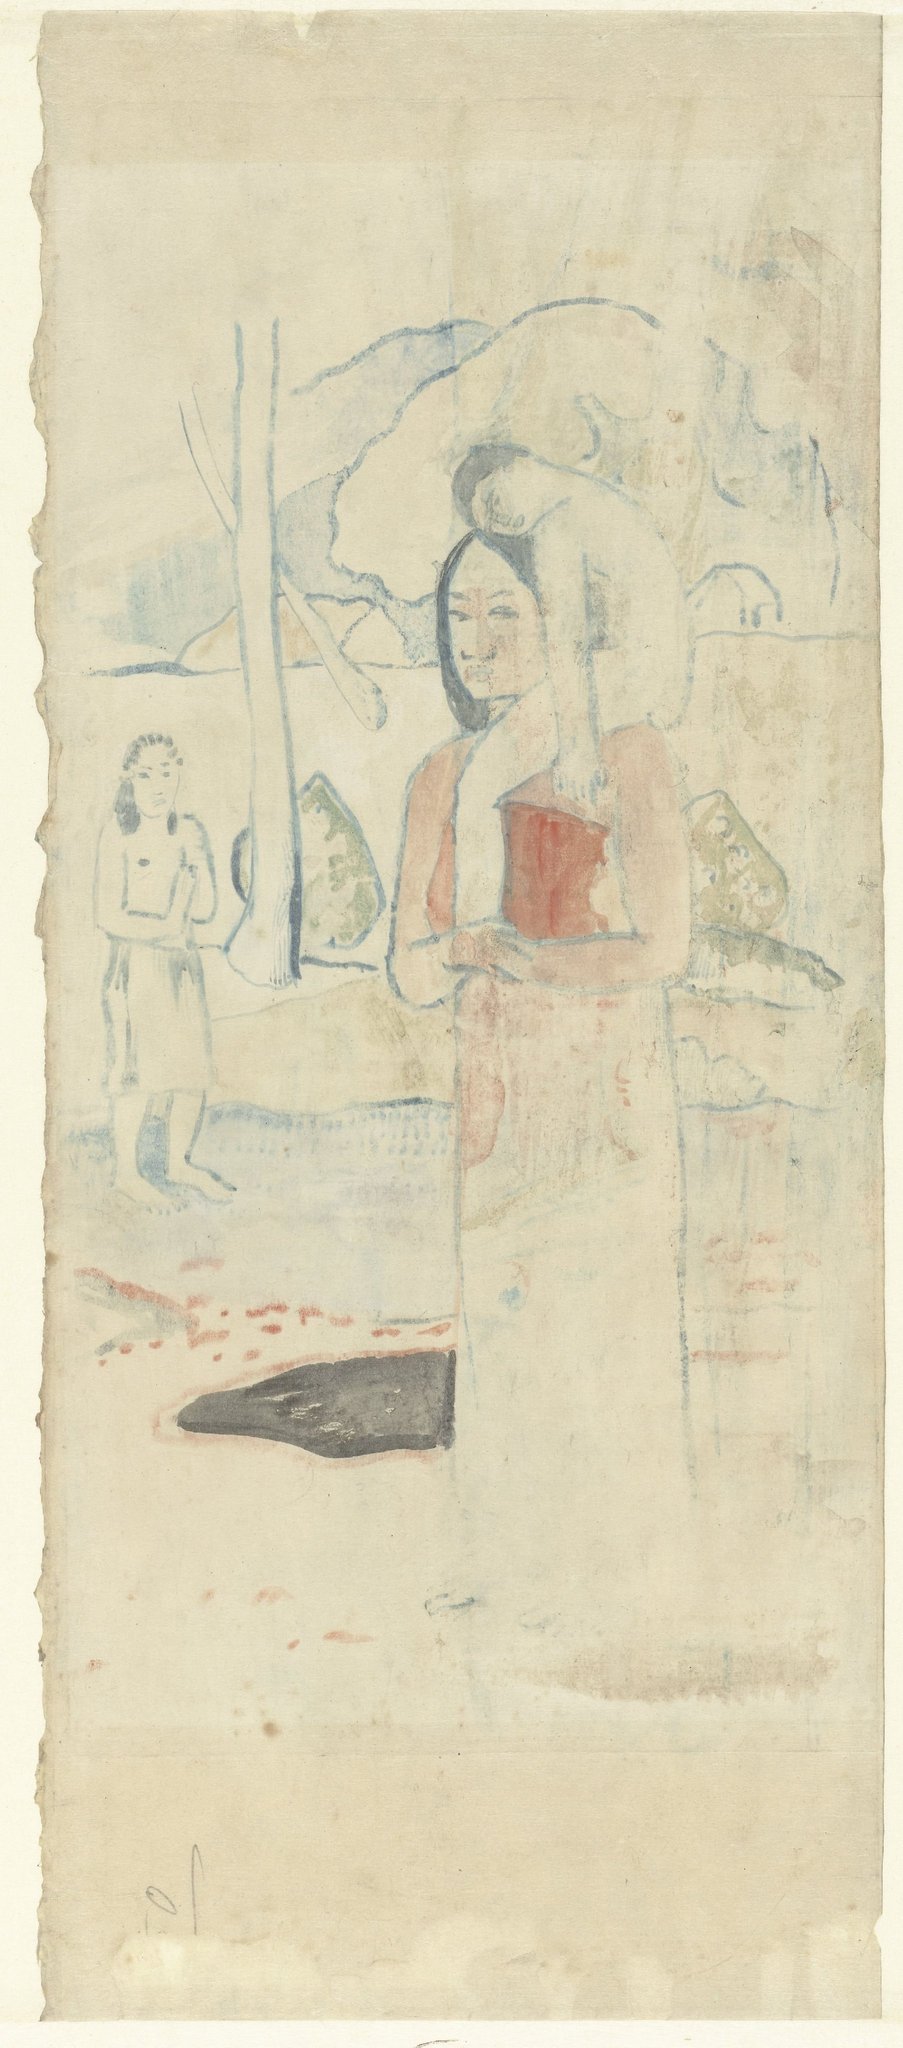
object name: print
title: Ia Orana Maria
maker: paul gauguin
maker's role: draughtsman, print maker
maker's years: 1848-1903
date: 1894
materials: paper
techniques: brush, printing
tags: madonna: mary standing (or half-length), christ-child close to her bosom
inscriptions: collector's mark: Lugt 2228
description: Maria als zwarte vrouw staat met een groot kind op haar schouder in een landschap op Tahiti. Op de achtergrond staat een vrouw met gevouwen handen. Bij deze unieke prent heeft de kunstenaar de monotype techniek toegepast waarbij hij op een glazen of metalen plaat in penseel met blauwe waterverf de contouren van de voorstelling aangaf en enkele vlakken met lichtrood en lichtgroen inkleurde. Voordat de verf was opgedroogd maakt hij een afdruk en mogelijk bracht hij daarna nog wat kleuraccenten aan met het penseel op de prent. Dit lijkt het geval bij het rood op de jurk en het zwarte vlak op de grond naast Maria.